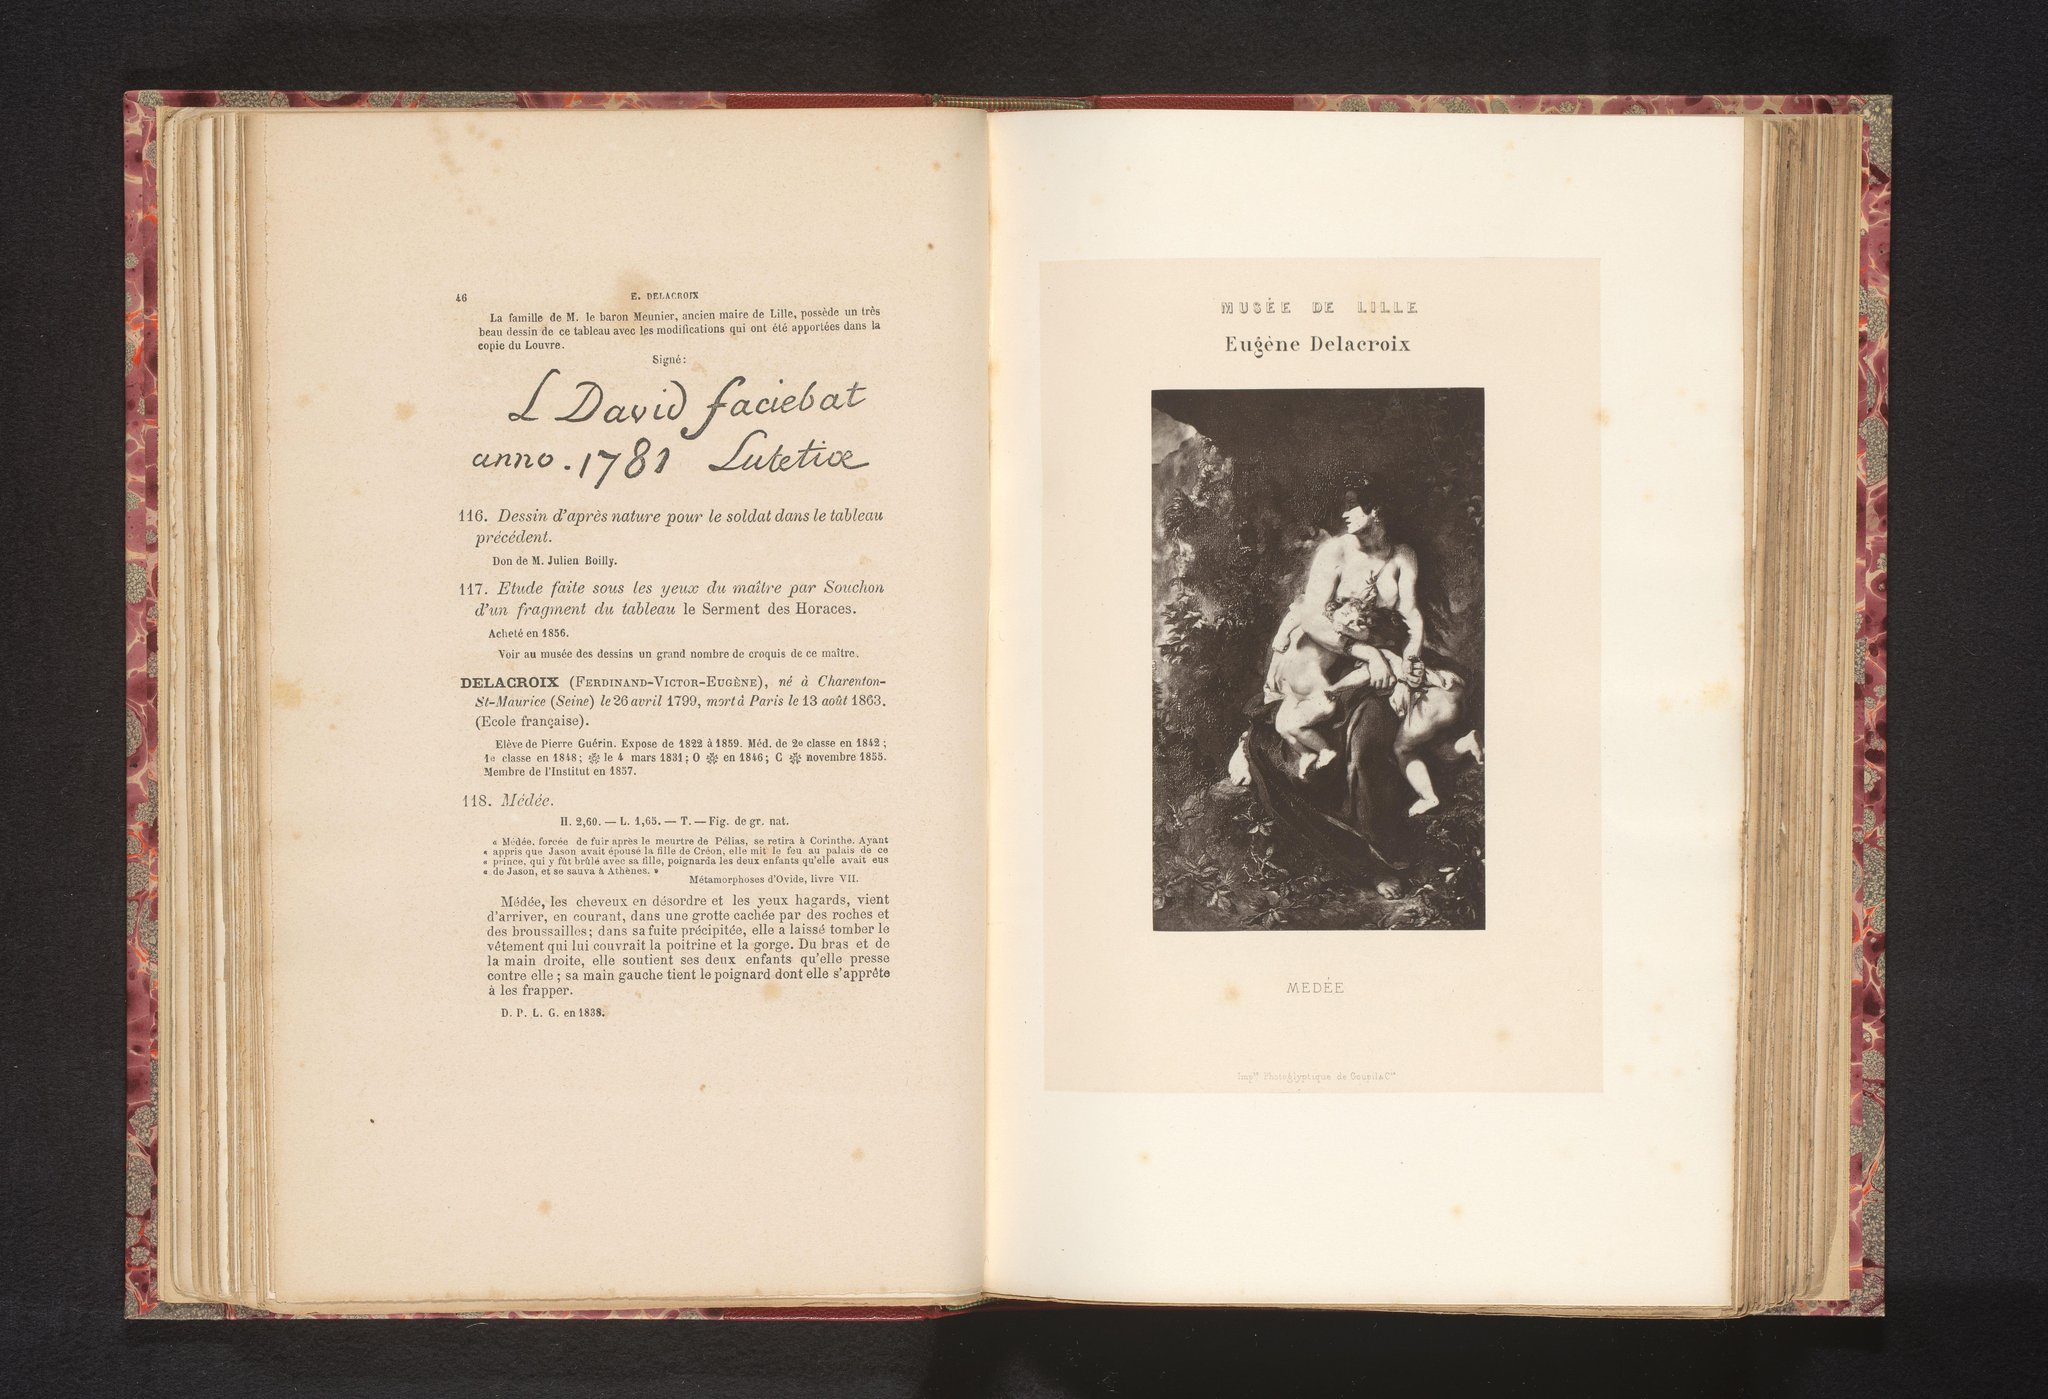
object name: reproduction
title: Medèe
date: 1862-1872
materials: paper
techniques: woodburytype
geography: lille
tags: medea